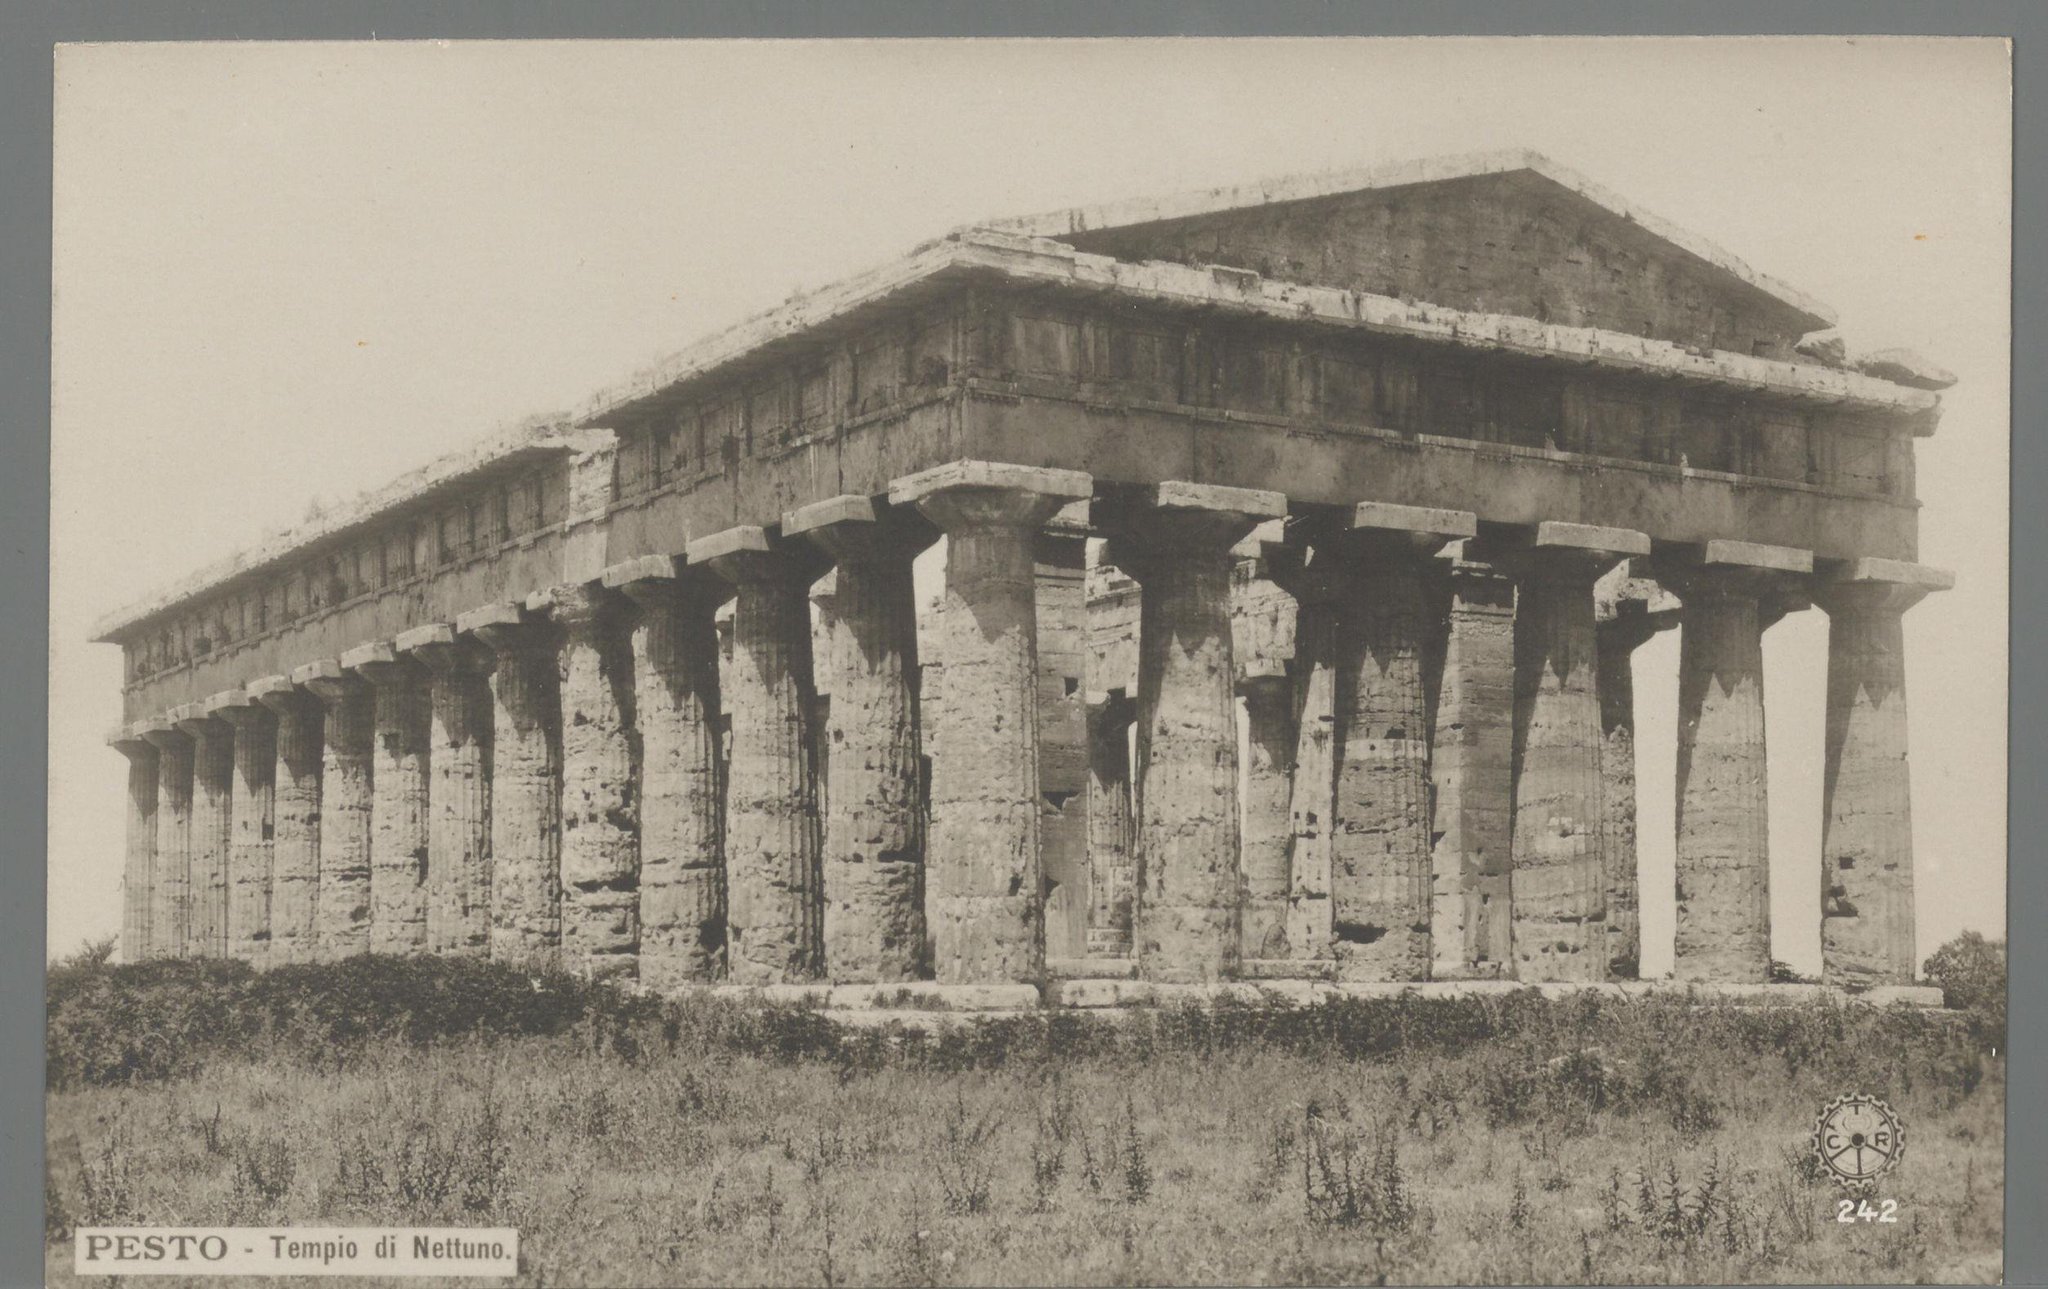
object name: ansichtkaart, prentbriefkaart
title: Pesto. Tempio de Nettune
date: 1906-1920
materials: photographic support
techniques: photography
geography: paestum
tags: column, pillar ~ architecture, temple, shrine ~ roman religion